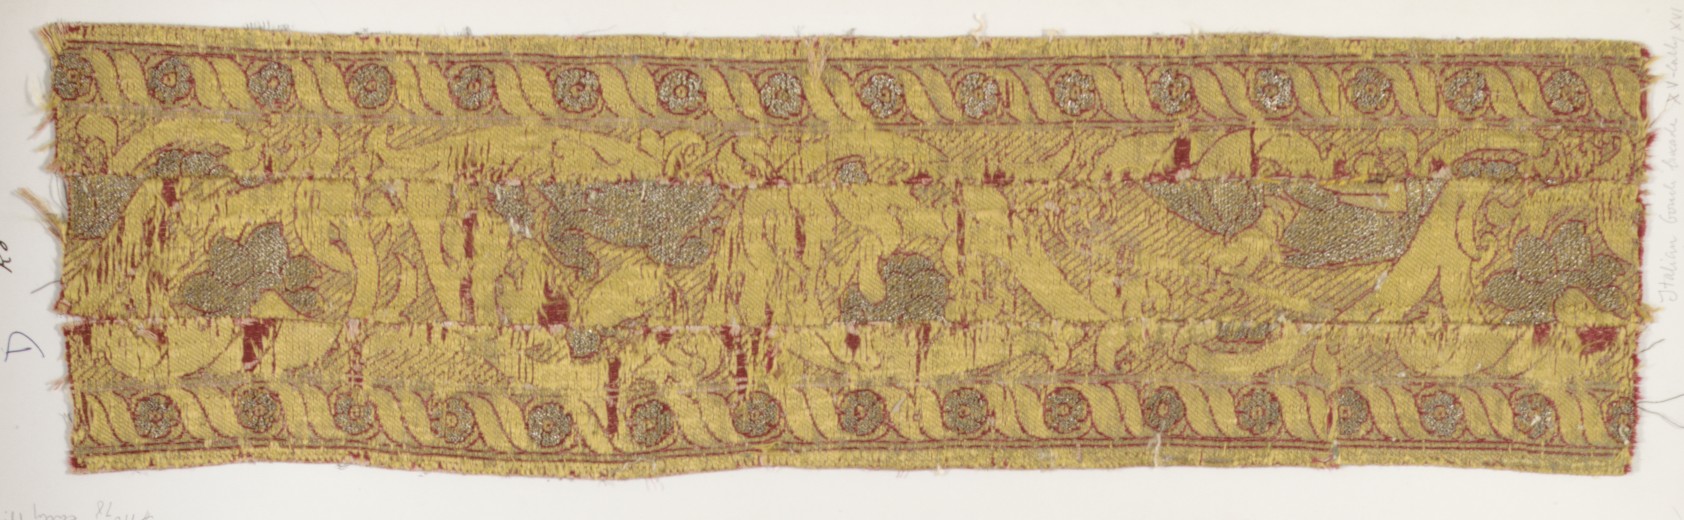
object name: fragment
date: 1401-1600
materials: metal thread, silk